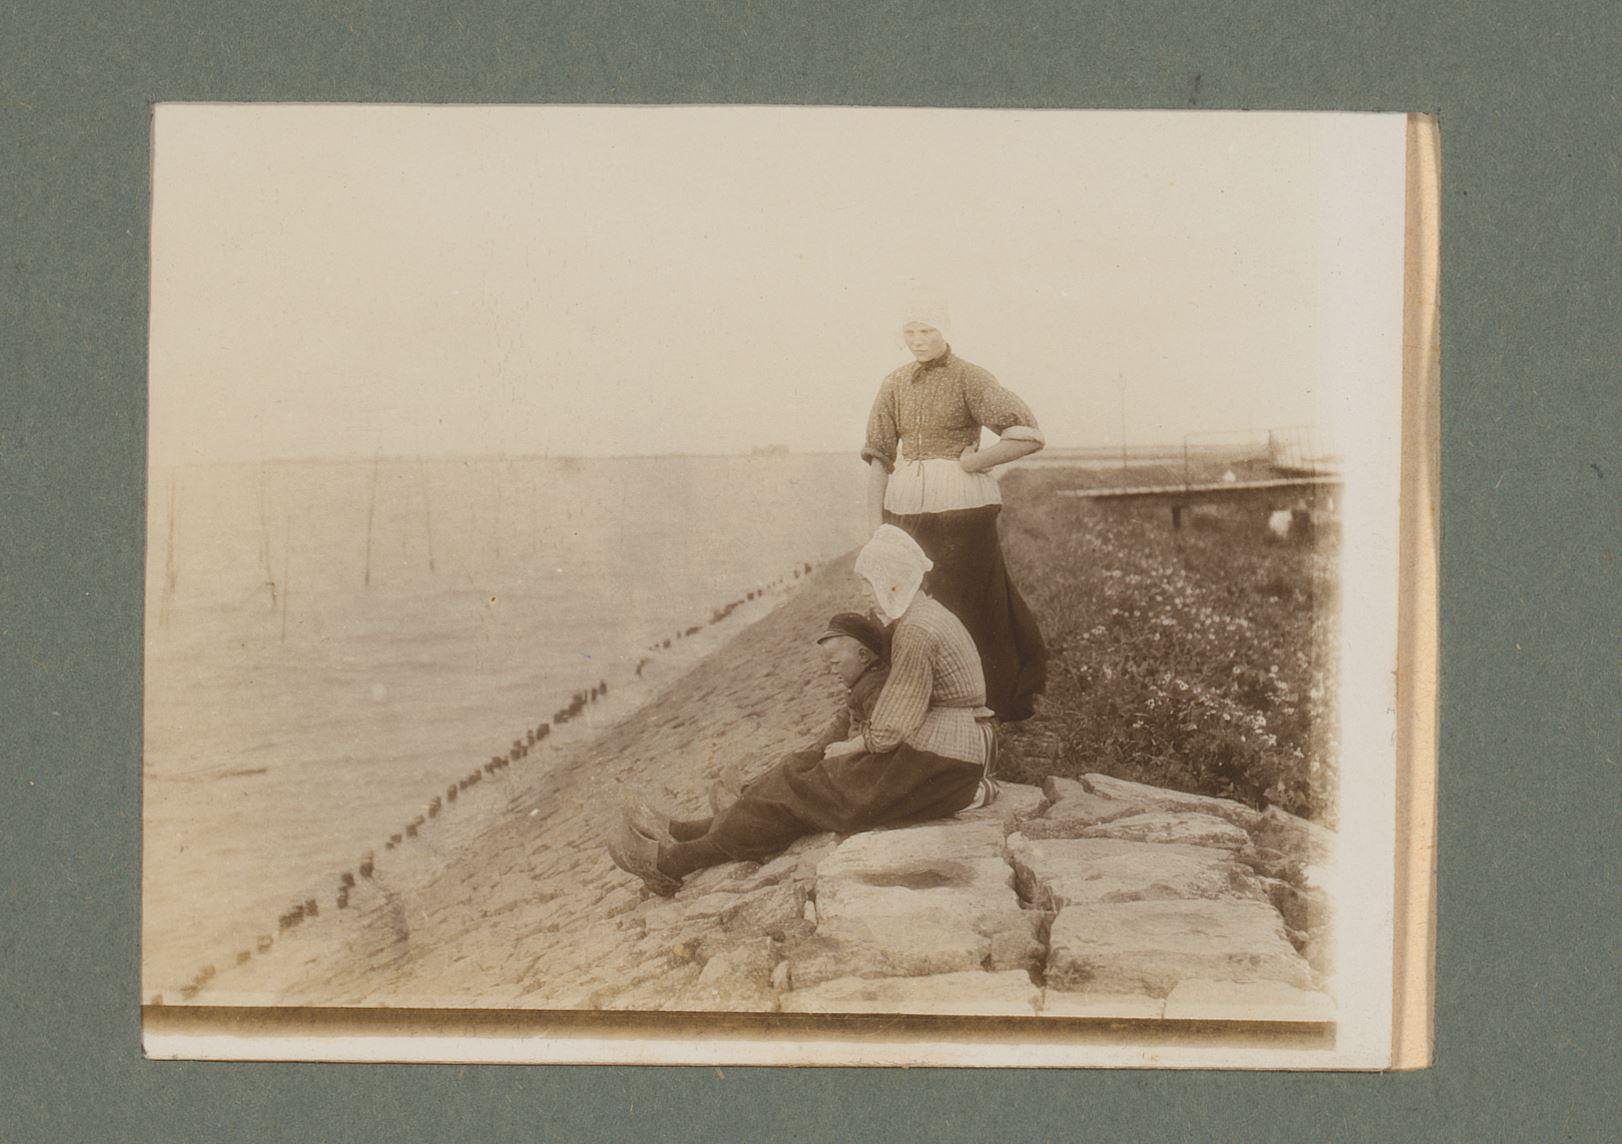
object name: photograph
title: Twee vrouwen en een kind in klederdracht op een dijk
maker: george hidderley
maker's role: fotograaf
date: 1920-1940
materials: photographic support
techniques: gelatin silver print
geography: netherlands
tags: folk costume, regional costume